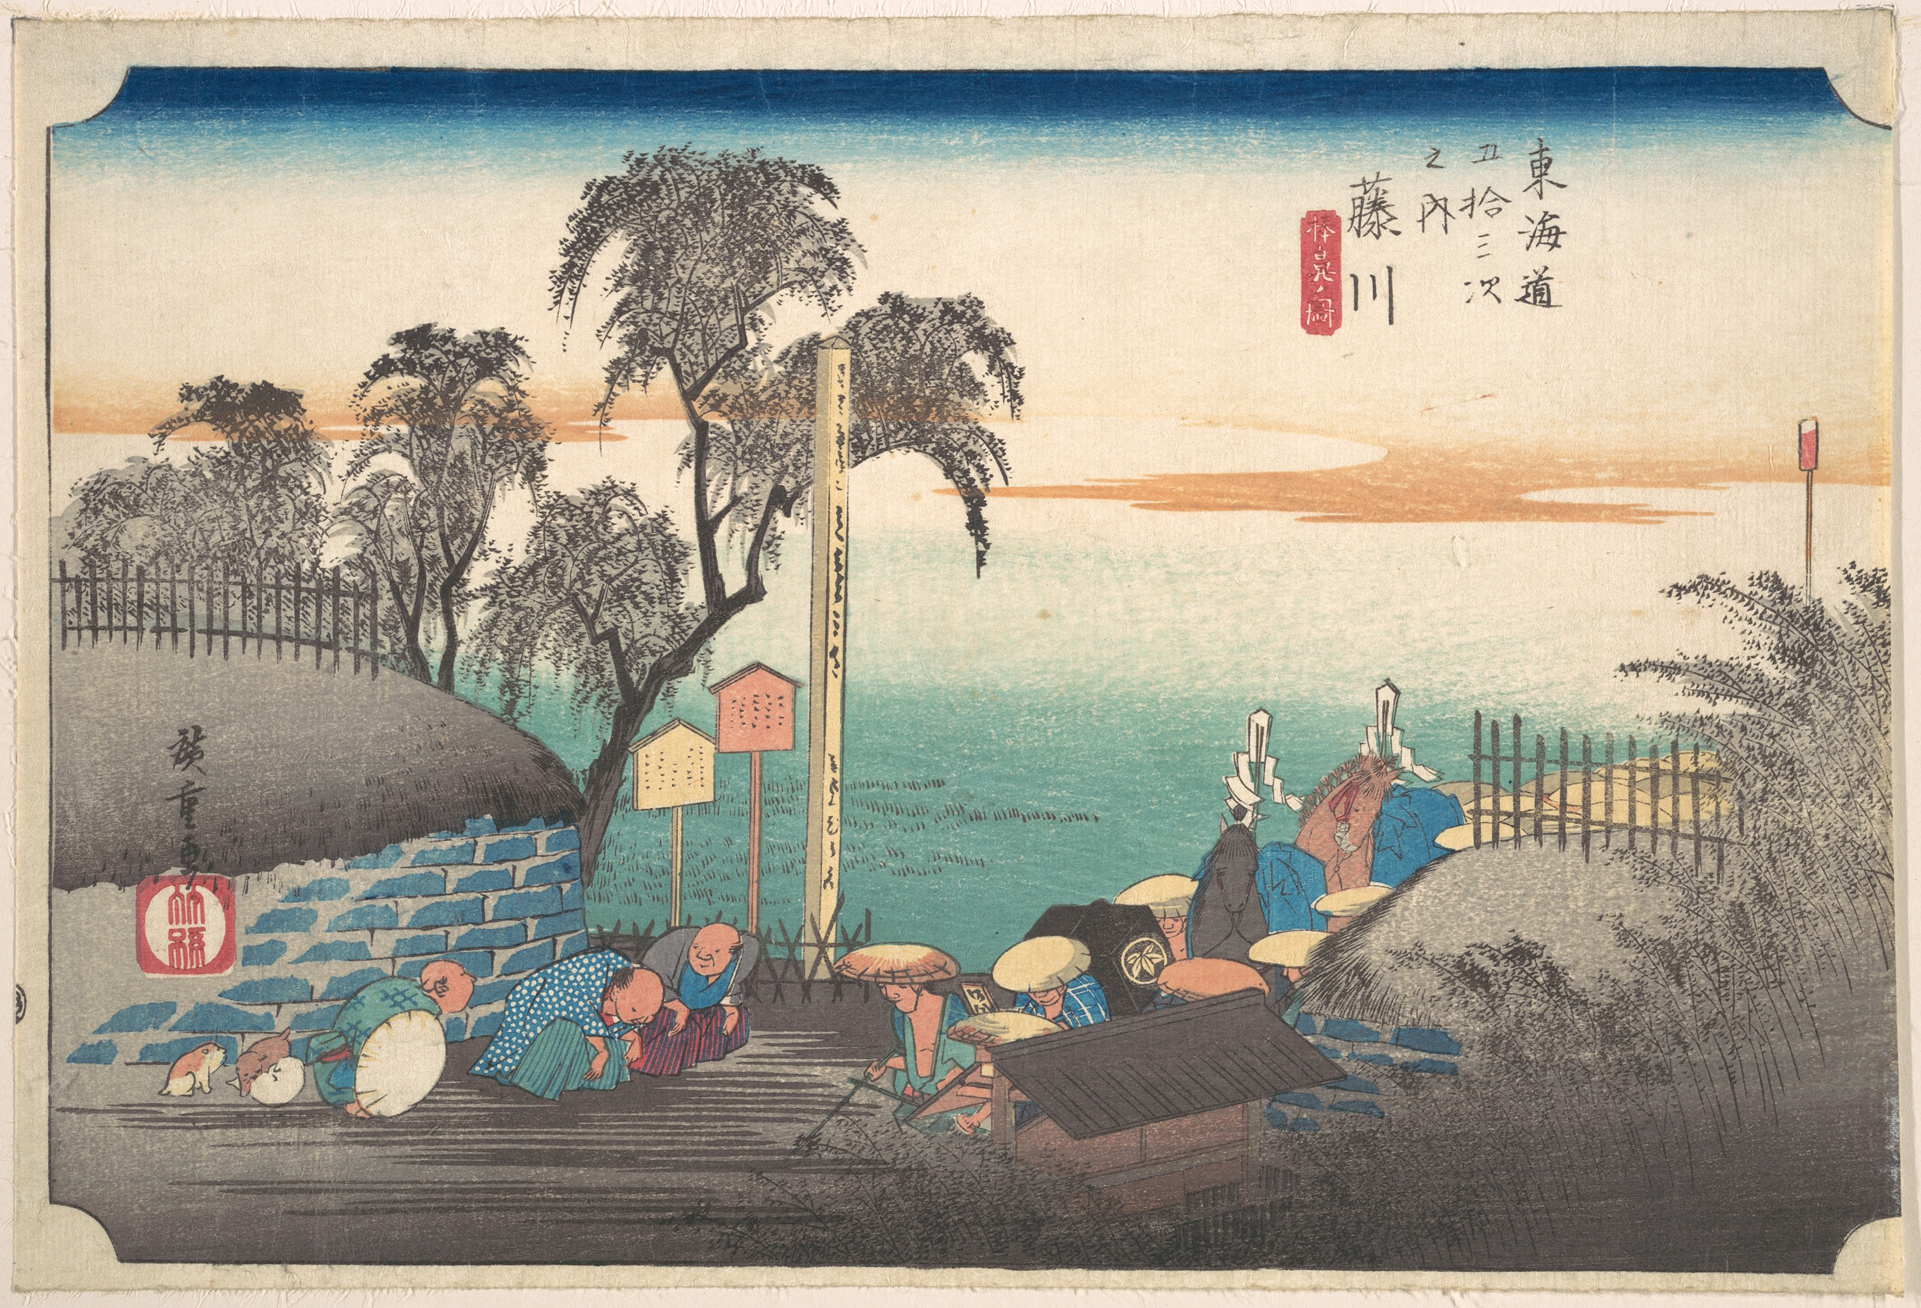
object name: print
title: Fujikawa, Bo Bana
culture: japanese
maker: utagawa hiroshige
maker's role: artist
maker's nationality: japanese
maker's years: 1797-1858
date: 1834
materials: ink, paper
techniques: woodblock print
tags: men,horses,landscapes